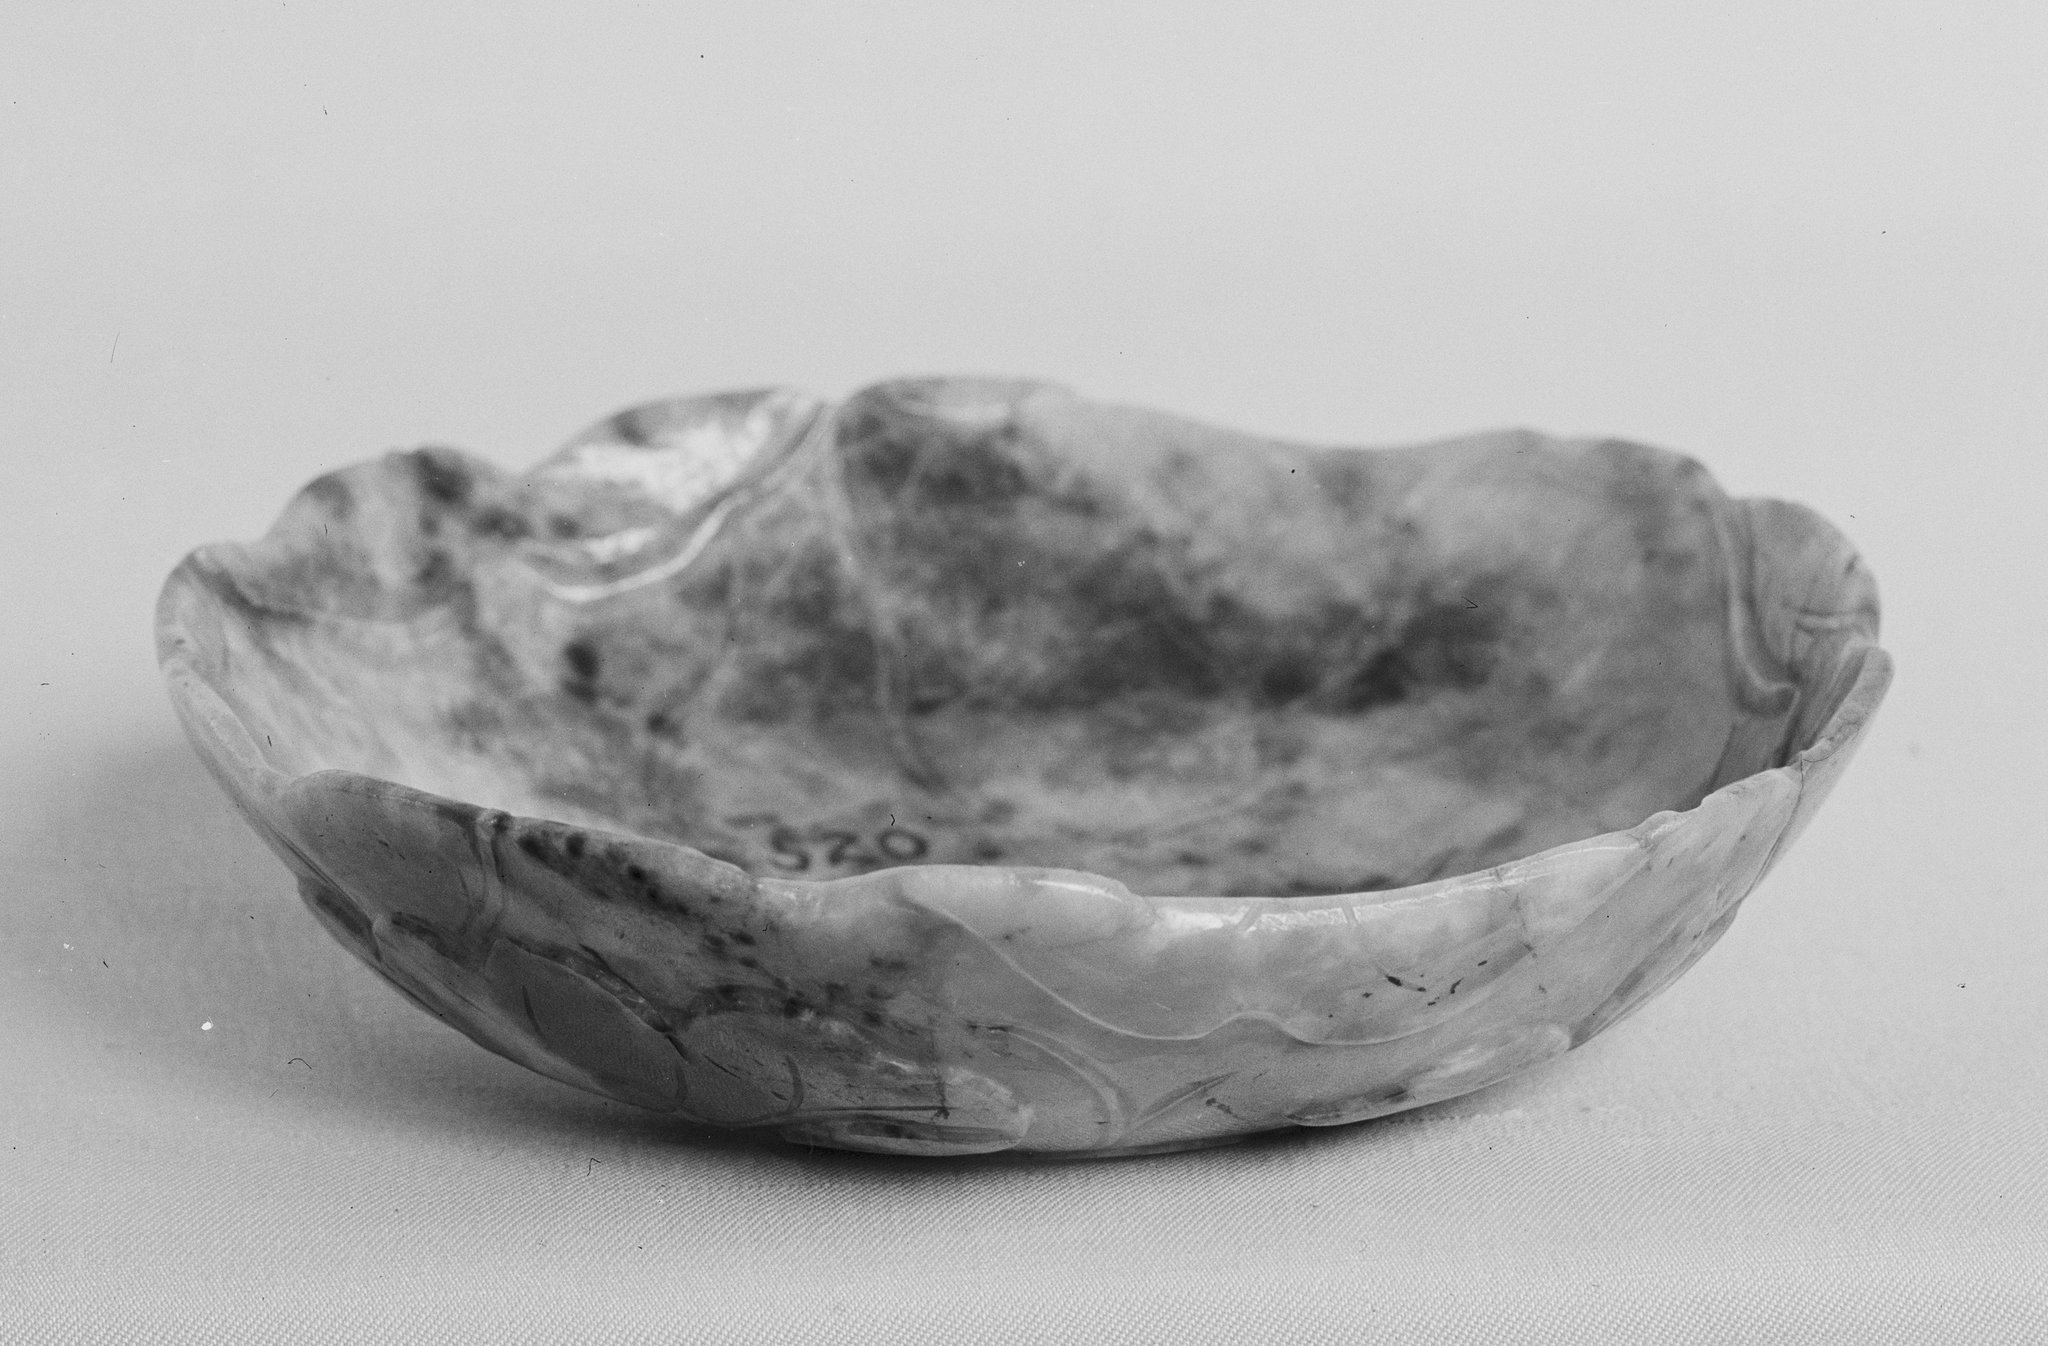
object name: dish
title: Miniature Dish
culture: chinese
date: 1736-1795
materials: jade